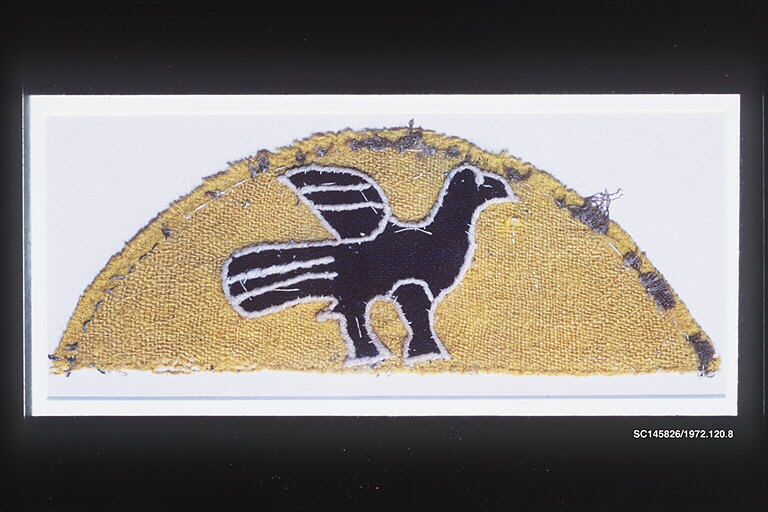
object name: textile fragment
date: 1301-1500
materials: wool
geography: egypt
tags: birds